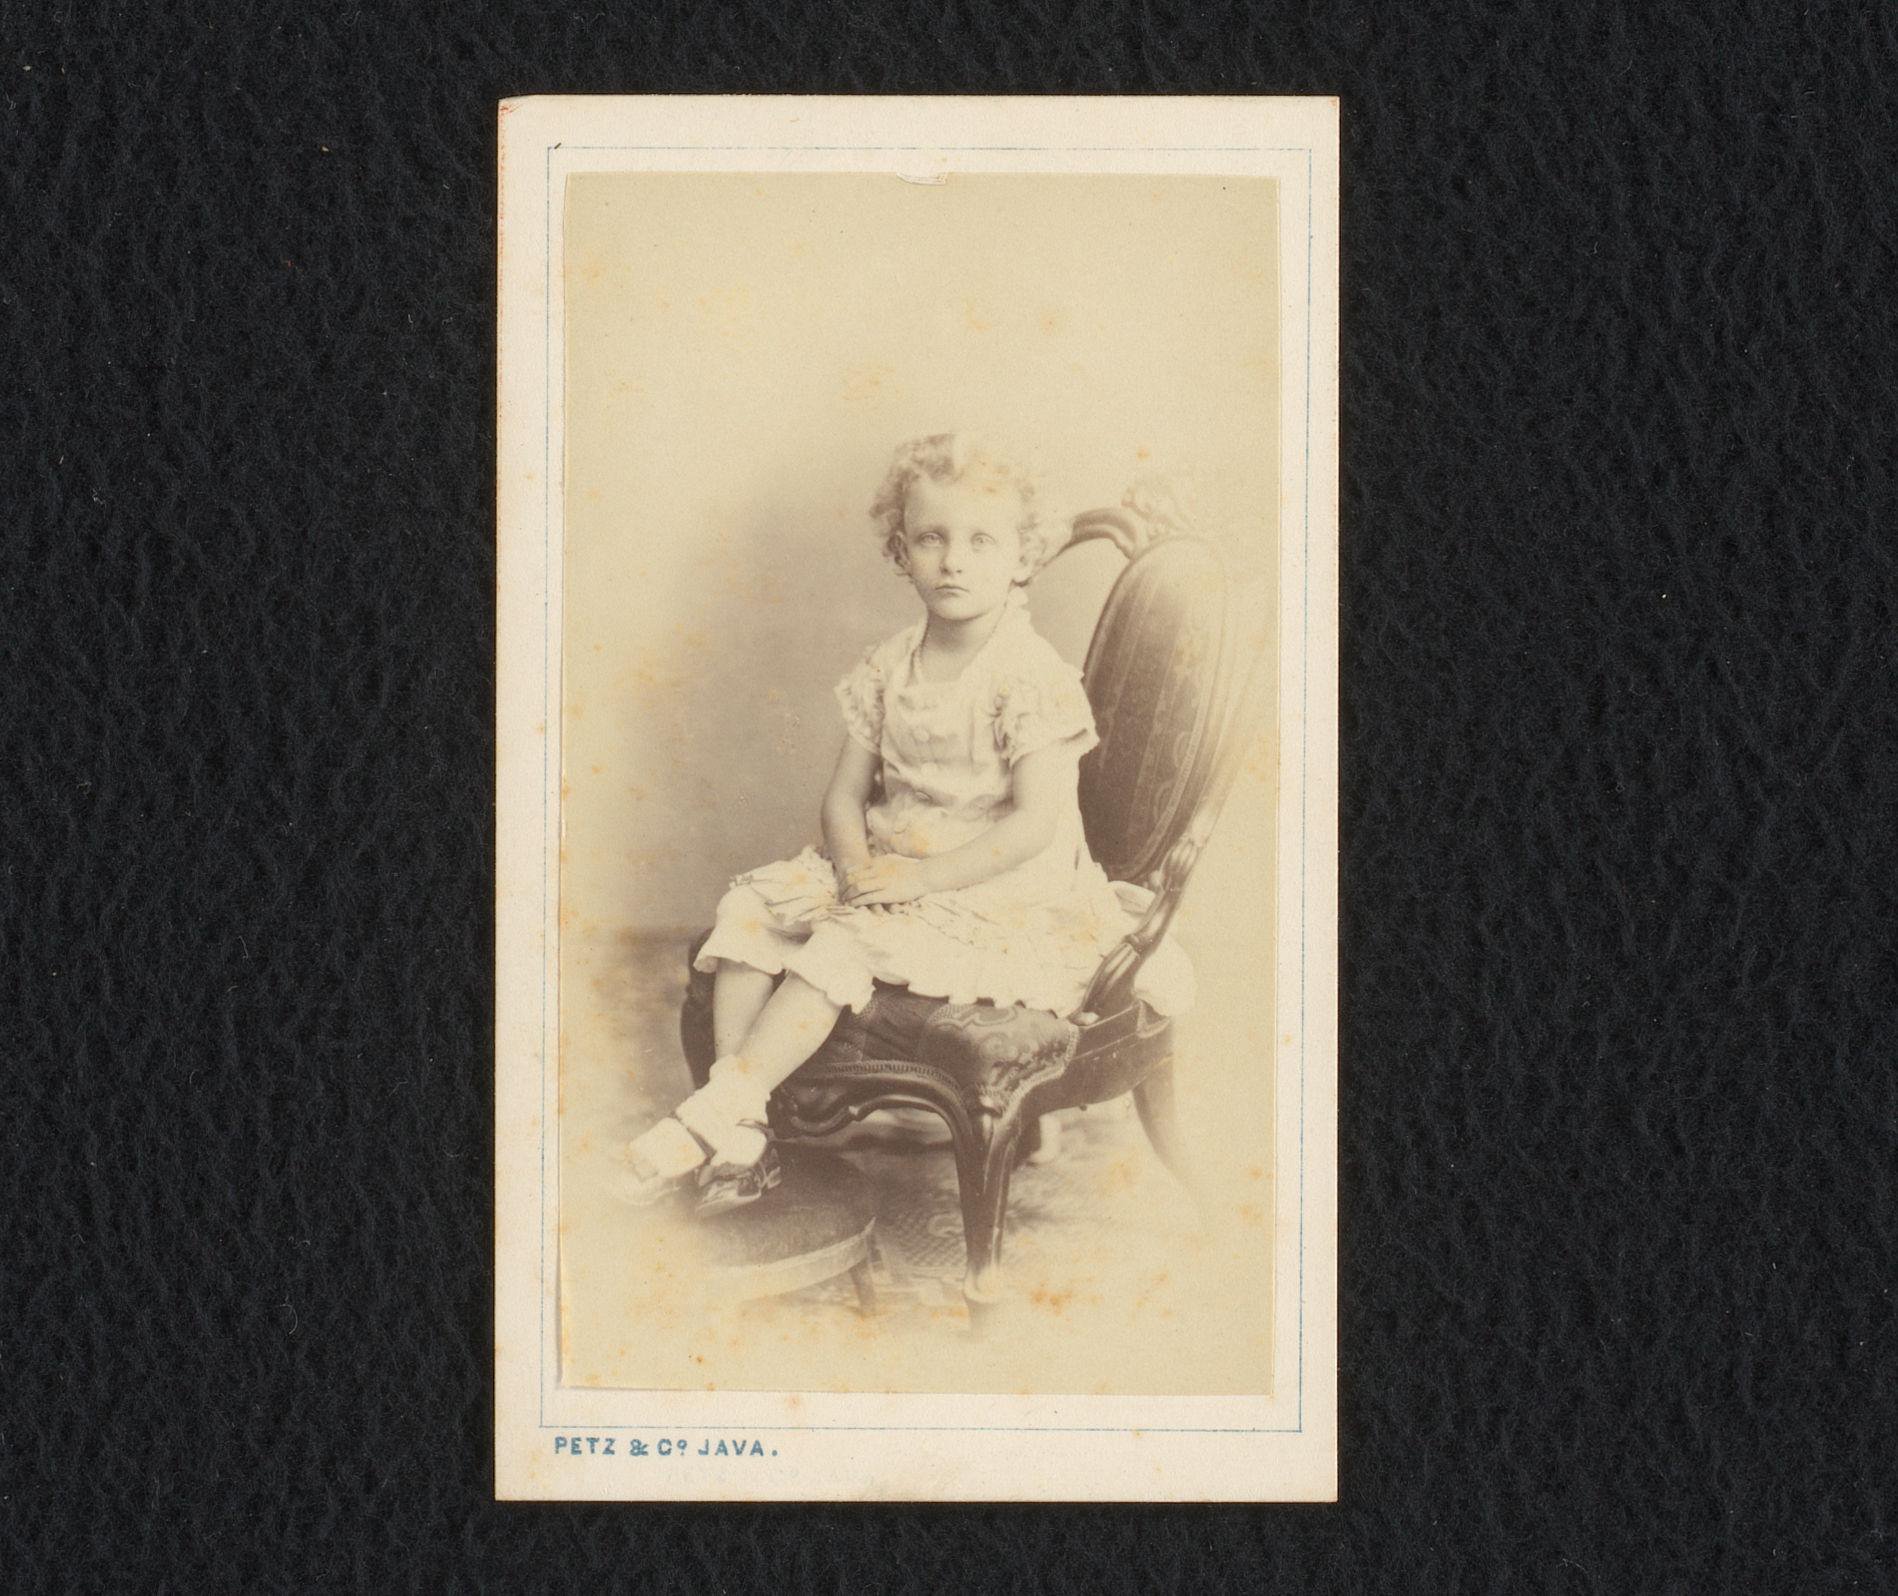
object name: photograph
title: Portret van Marij F.P. Zeper uit Aardenburg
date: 1883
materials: cardboard, paper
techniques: albumen print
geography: batavia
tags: historical persons - bb - woman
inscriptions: inscription: ‘Marij F.P. Zeper 15/8 79./ Aardenburg, 4 1/2 Jaar’